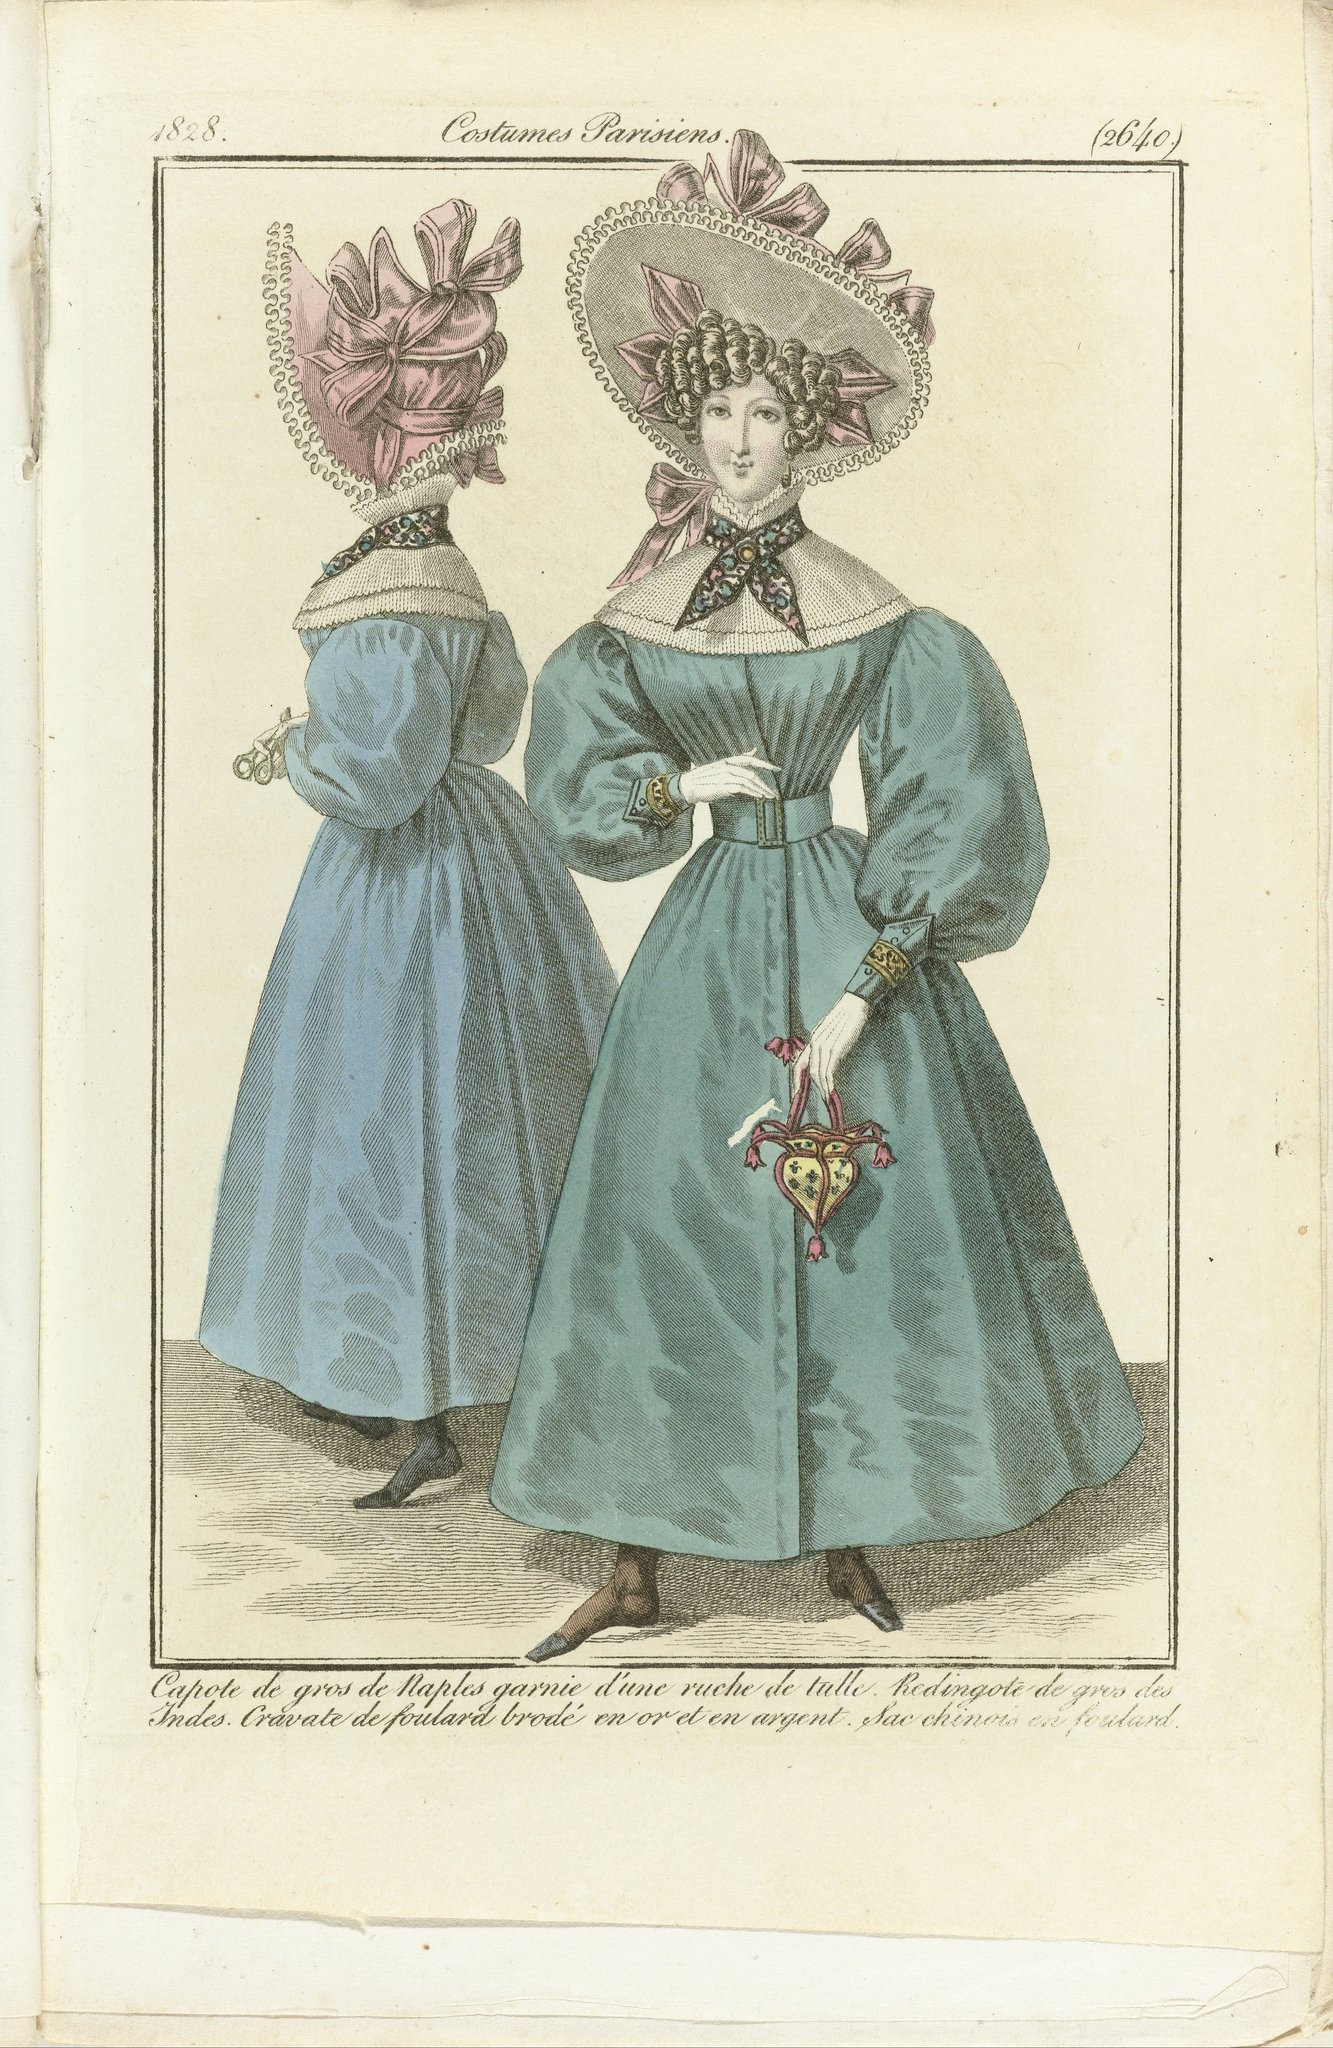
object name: fashion print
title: Journal des Dames et des Modes 1828, Costumes Parisiens (2640)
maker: Anonymous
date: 1828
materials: paper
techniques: etching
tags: fashion plates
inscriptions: date